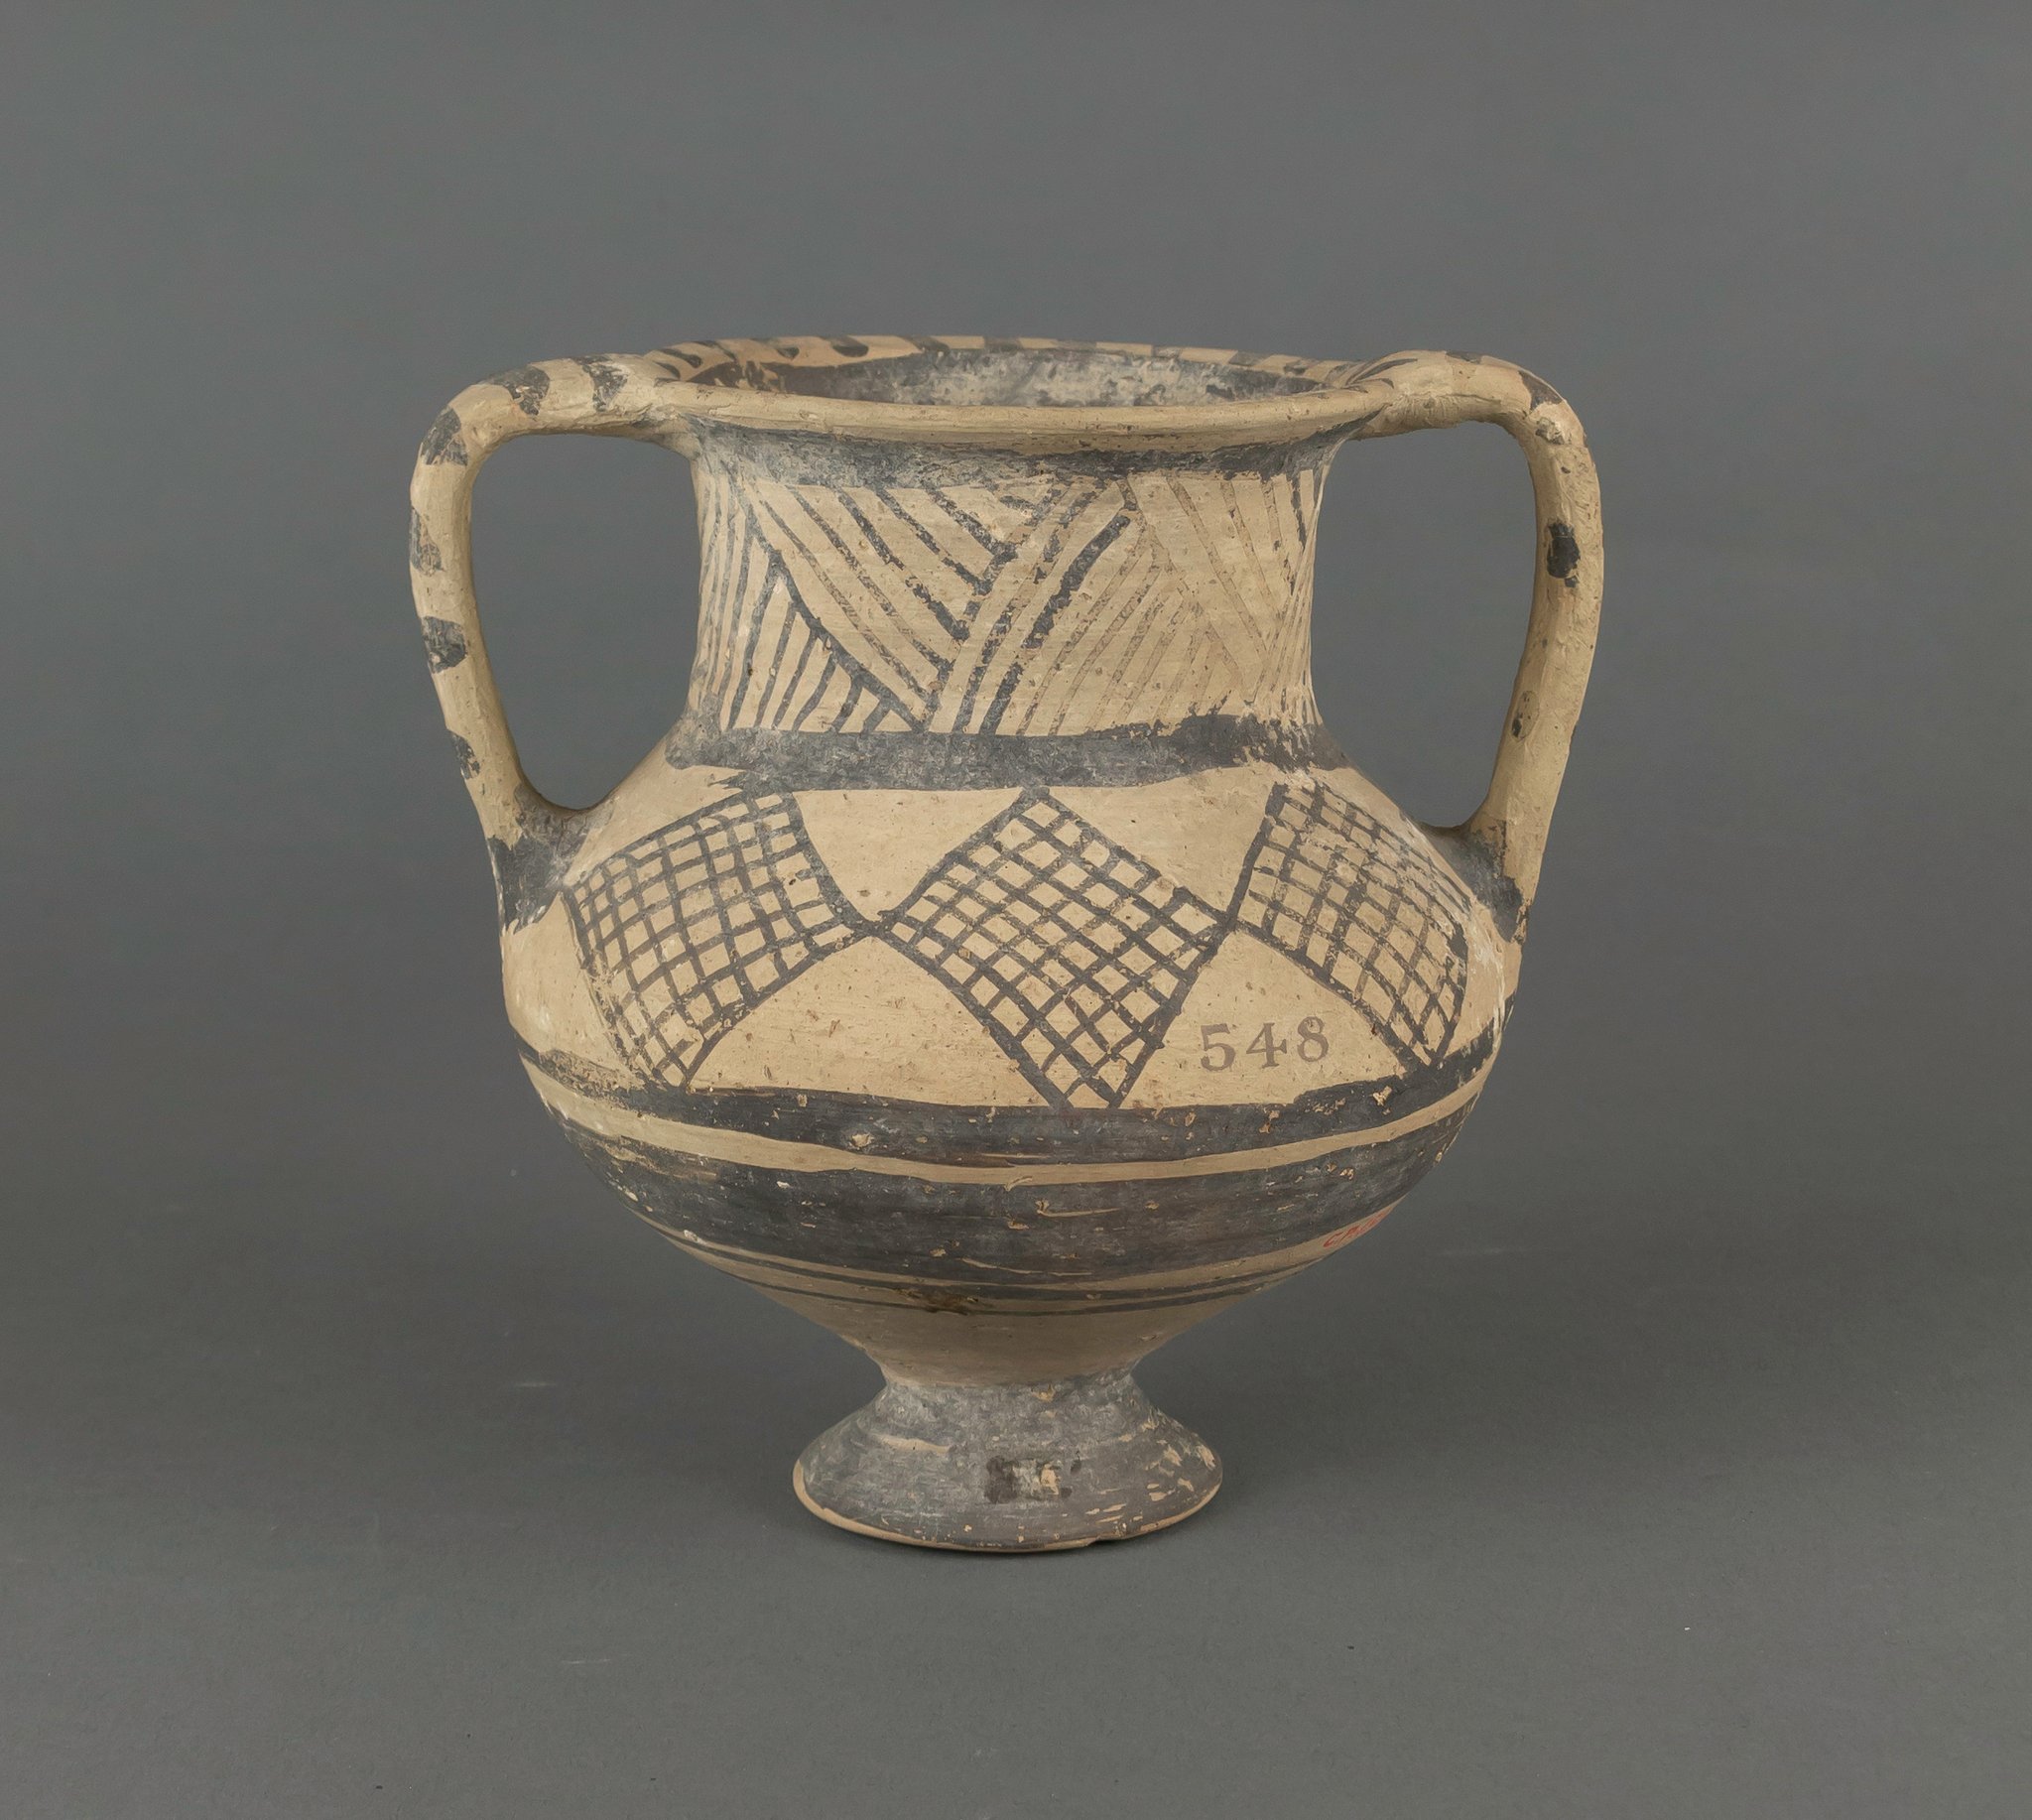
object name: amphoriskos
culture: cypriot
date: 850-750 BCE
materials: terracotta